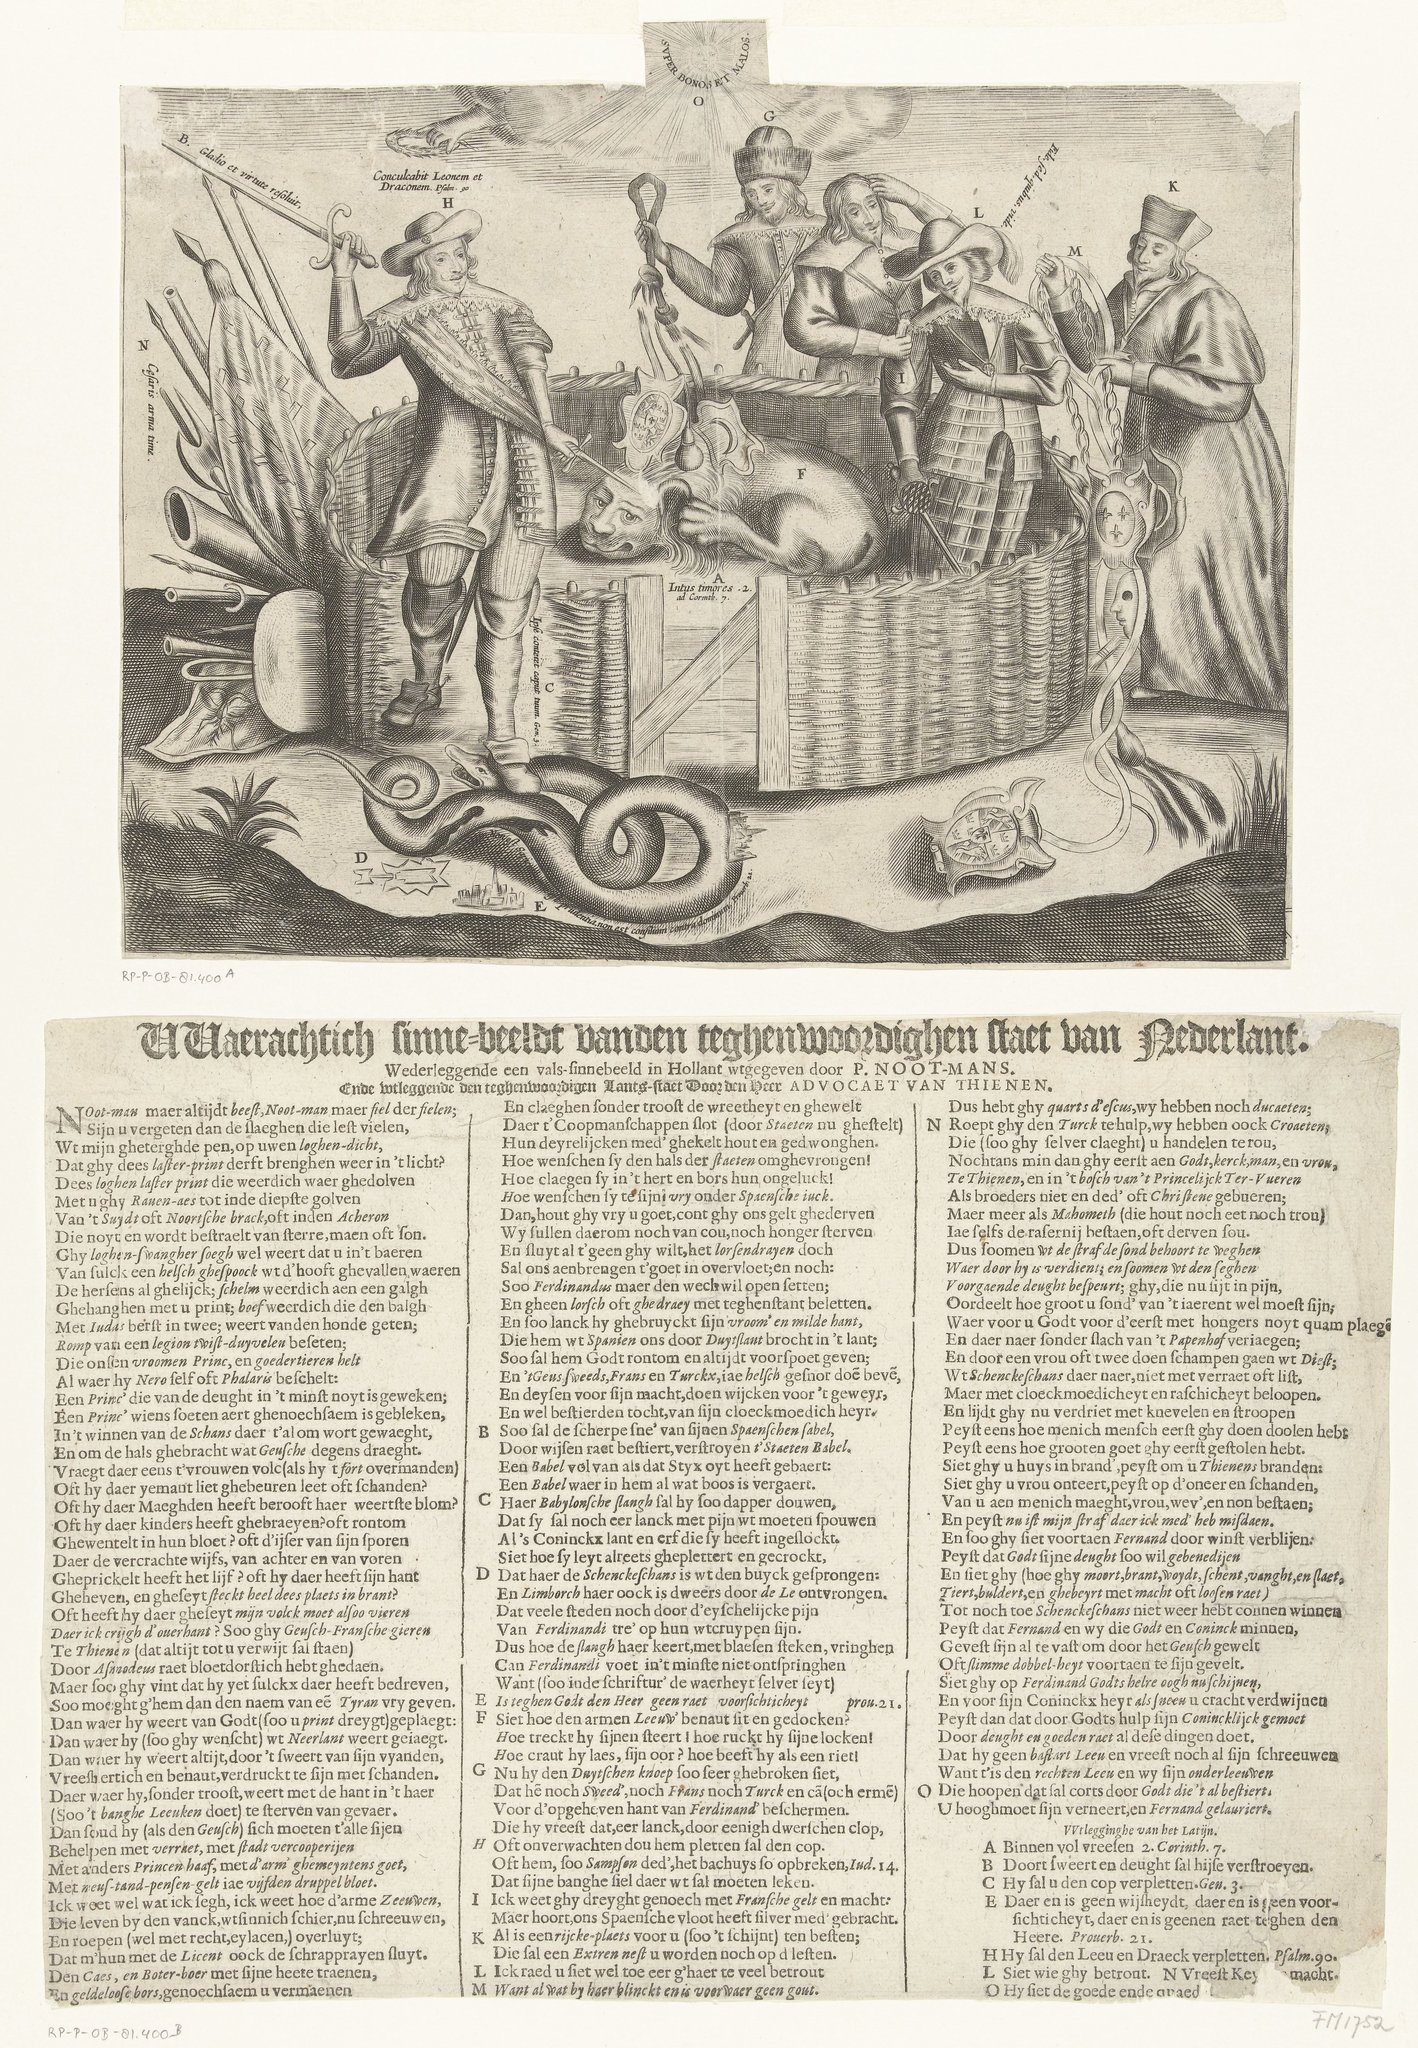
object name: print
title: Allegorie tegen Frederik Hendrik, 1636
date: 1636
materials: paper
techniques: engraving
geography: southern netherlands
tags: delft, frederick henry (prince of orange), paris, armand-jean du plessis hertog van richelieu, brussels, landvoogd der zuidelijke nederlanden ferdinand van oostenrijk, fenced or walled garden; 'hortus conclusus'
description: Allegorie op de politieke situatie in het jaar 1636. Frederik Hendrik en de Nederlandse Leeuw zitten angstig opgesloten in de Hollandse Tuin. Links vertrapt Ferdinand een slang waardoor de steden Schenckenschans, Limburg en Dalen uit haar buik springen. Rechts biedt kardinaal Richelieu de stadhouder een ereketting aan. De prent is een antwoord op FMH 1751. Bij de prent behoort een tekstblad.